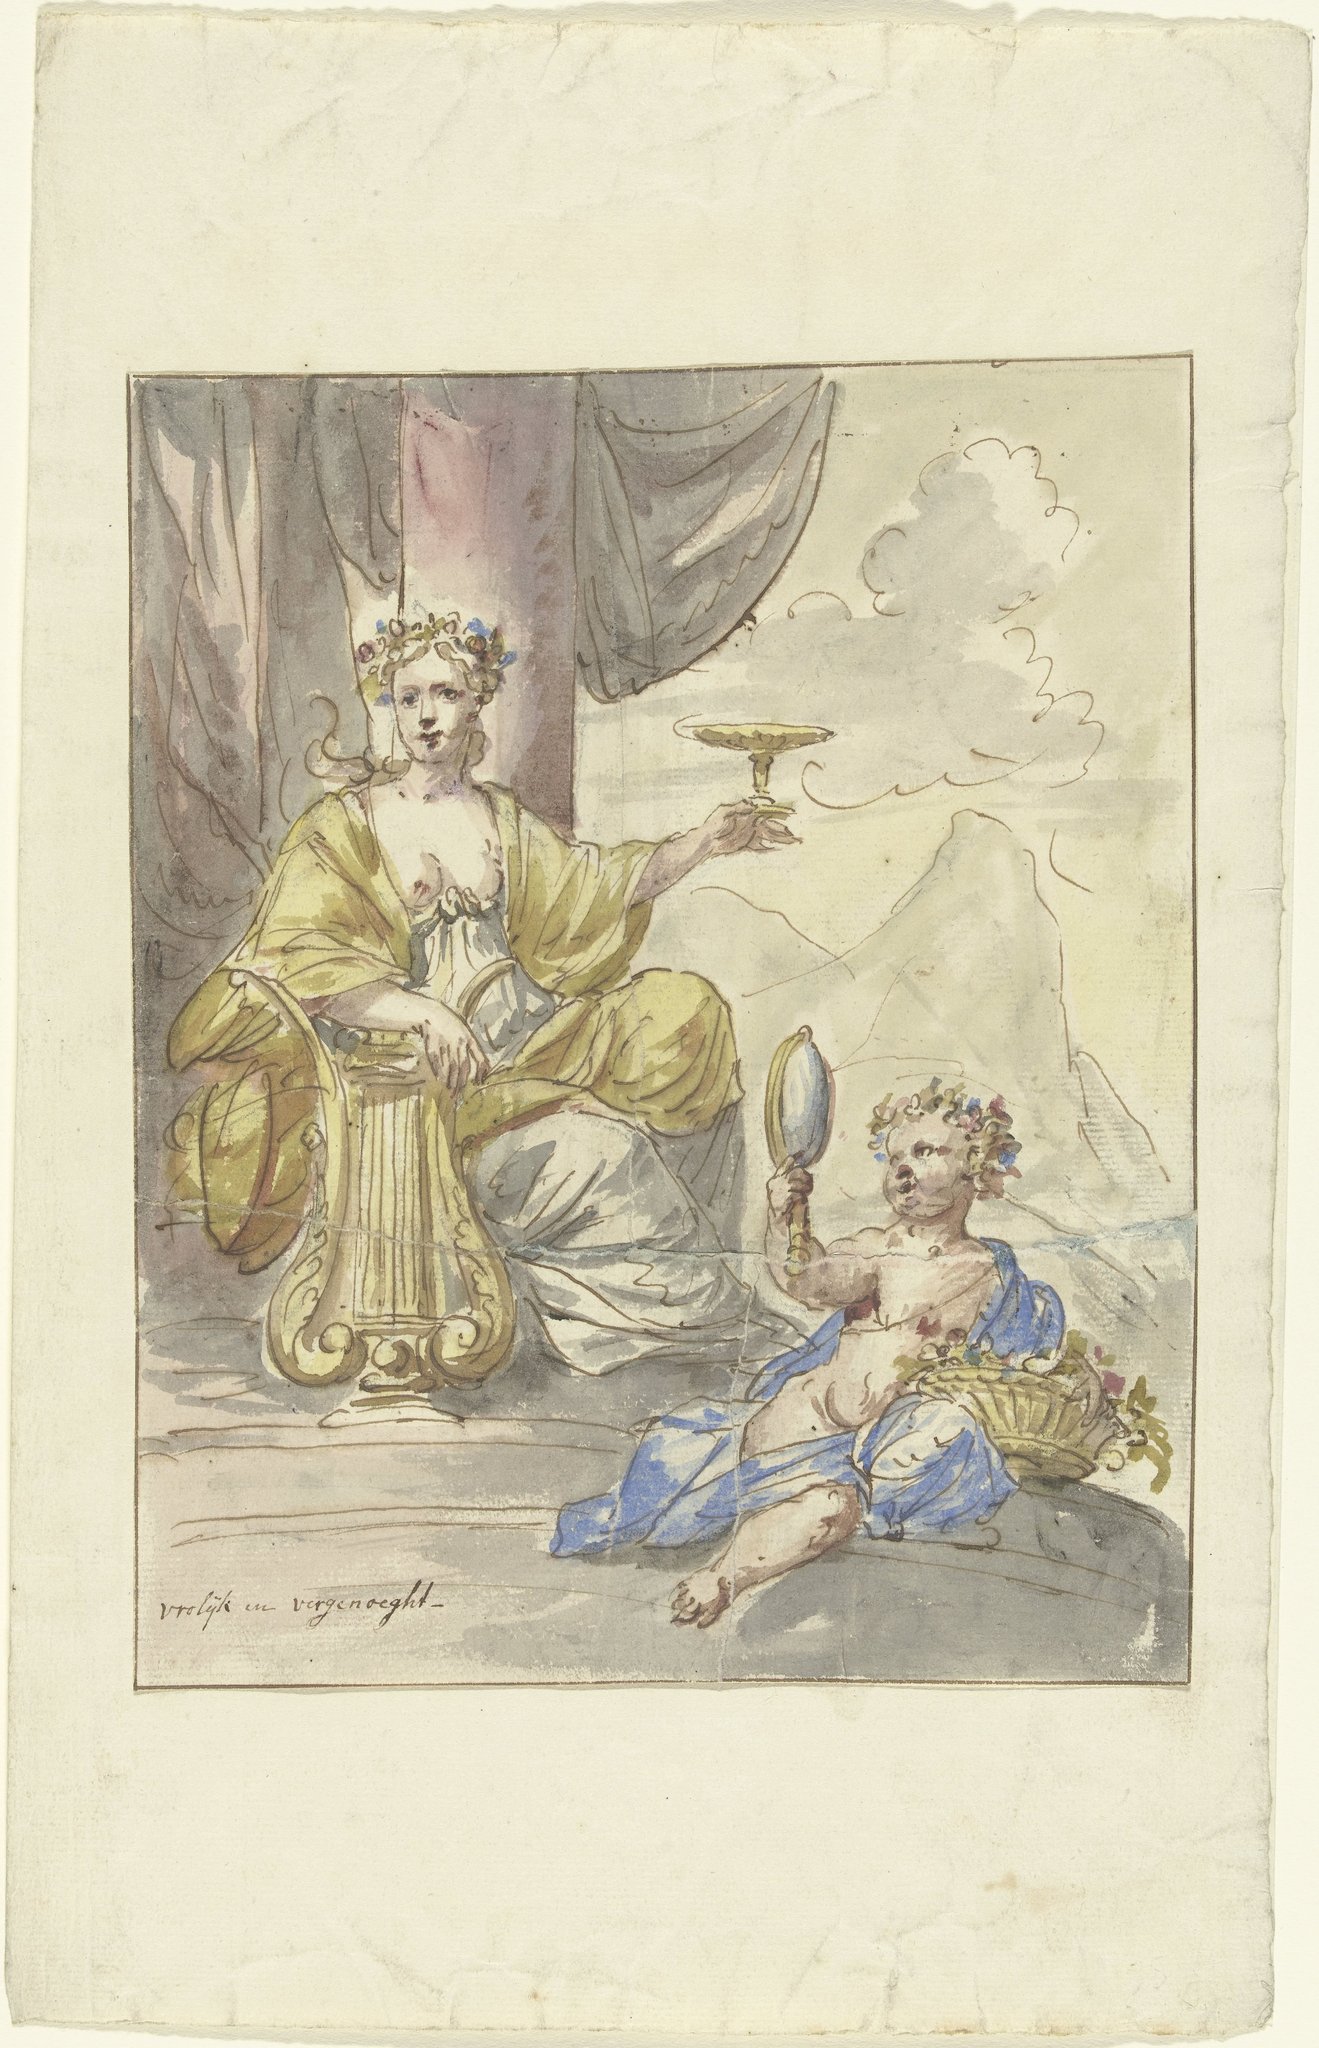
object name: design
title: Allegorie op Vrolijkheid en Genoegen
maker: elias van nijmegen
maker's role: draughtsman, painter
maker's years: 1667-1755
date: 1677-1755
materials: ink, paper, pencil, watercolor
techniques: brush, pen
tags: pleasure, enjoyment, joy; 'allegrezza', 'allegrezza da le medaglie', 'allegrezza, letitia e giubilo', 'diletto', 'piacere', 'piacere honesto' (ripa)